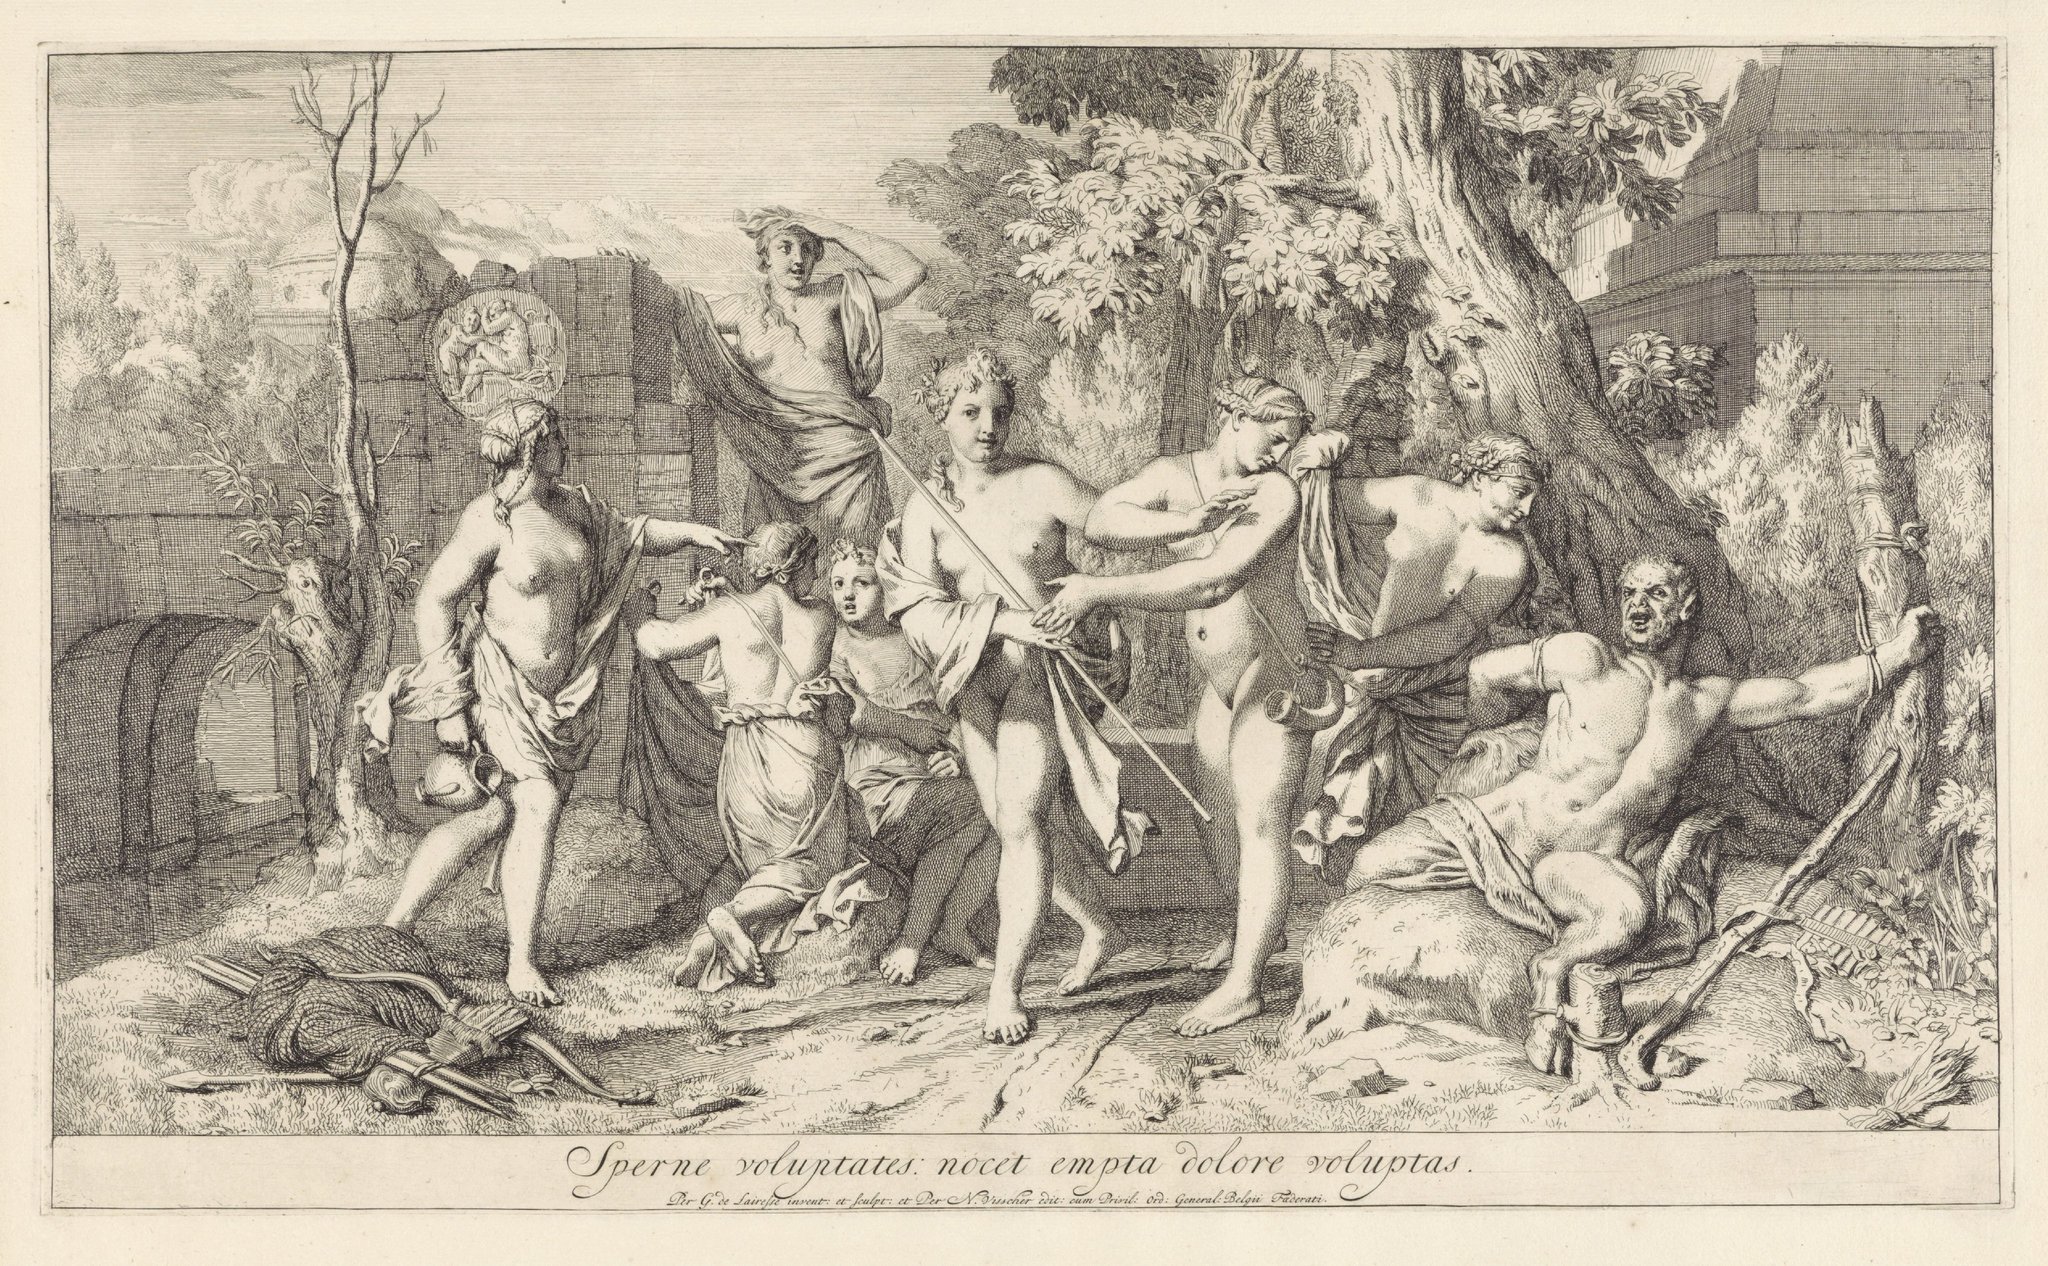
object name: print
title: Sperne voluptates: nocet empta dolore voluptas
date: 1685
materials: paper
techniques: etching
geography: amsterdam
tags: nymphs (in general); 'ninfe in commune' (ripa), mocking, insulting; teasing, satyr(s) (in general)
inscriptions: collector's mark: Lugt 240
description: In een landschap is een sater met beide armen aan een boom vastgebonden. Naast hem staan nimfen die hem bespotten.